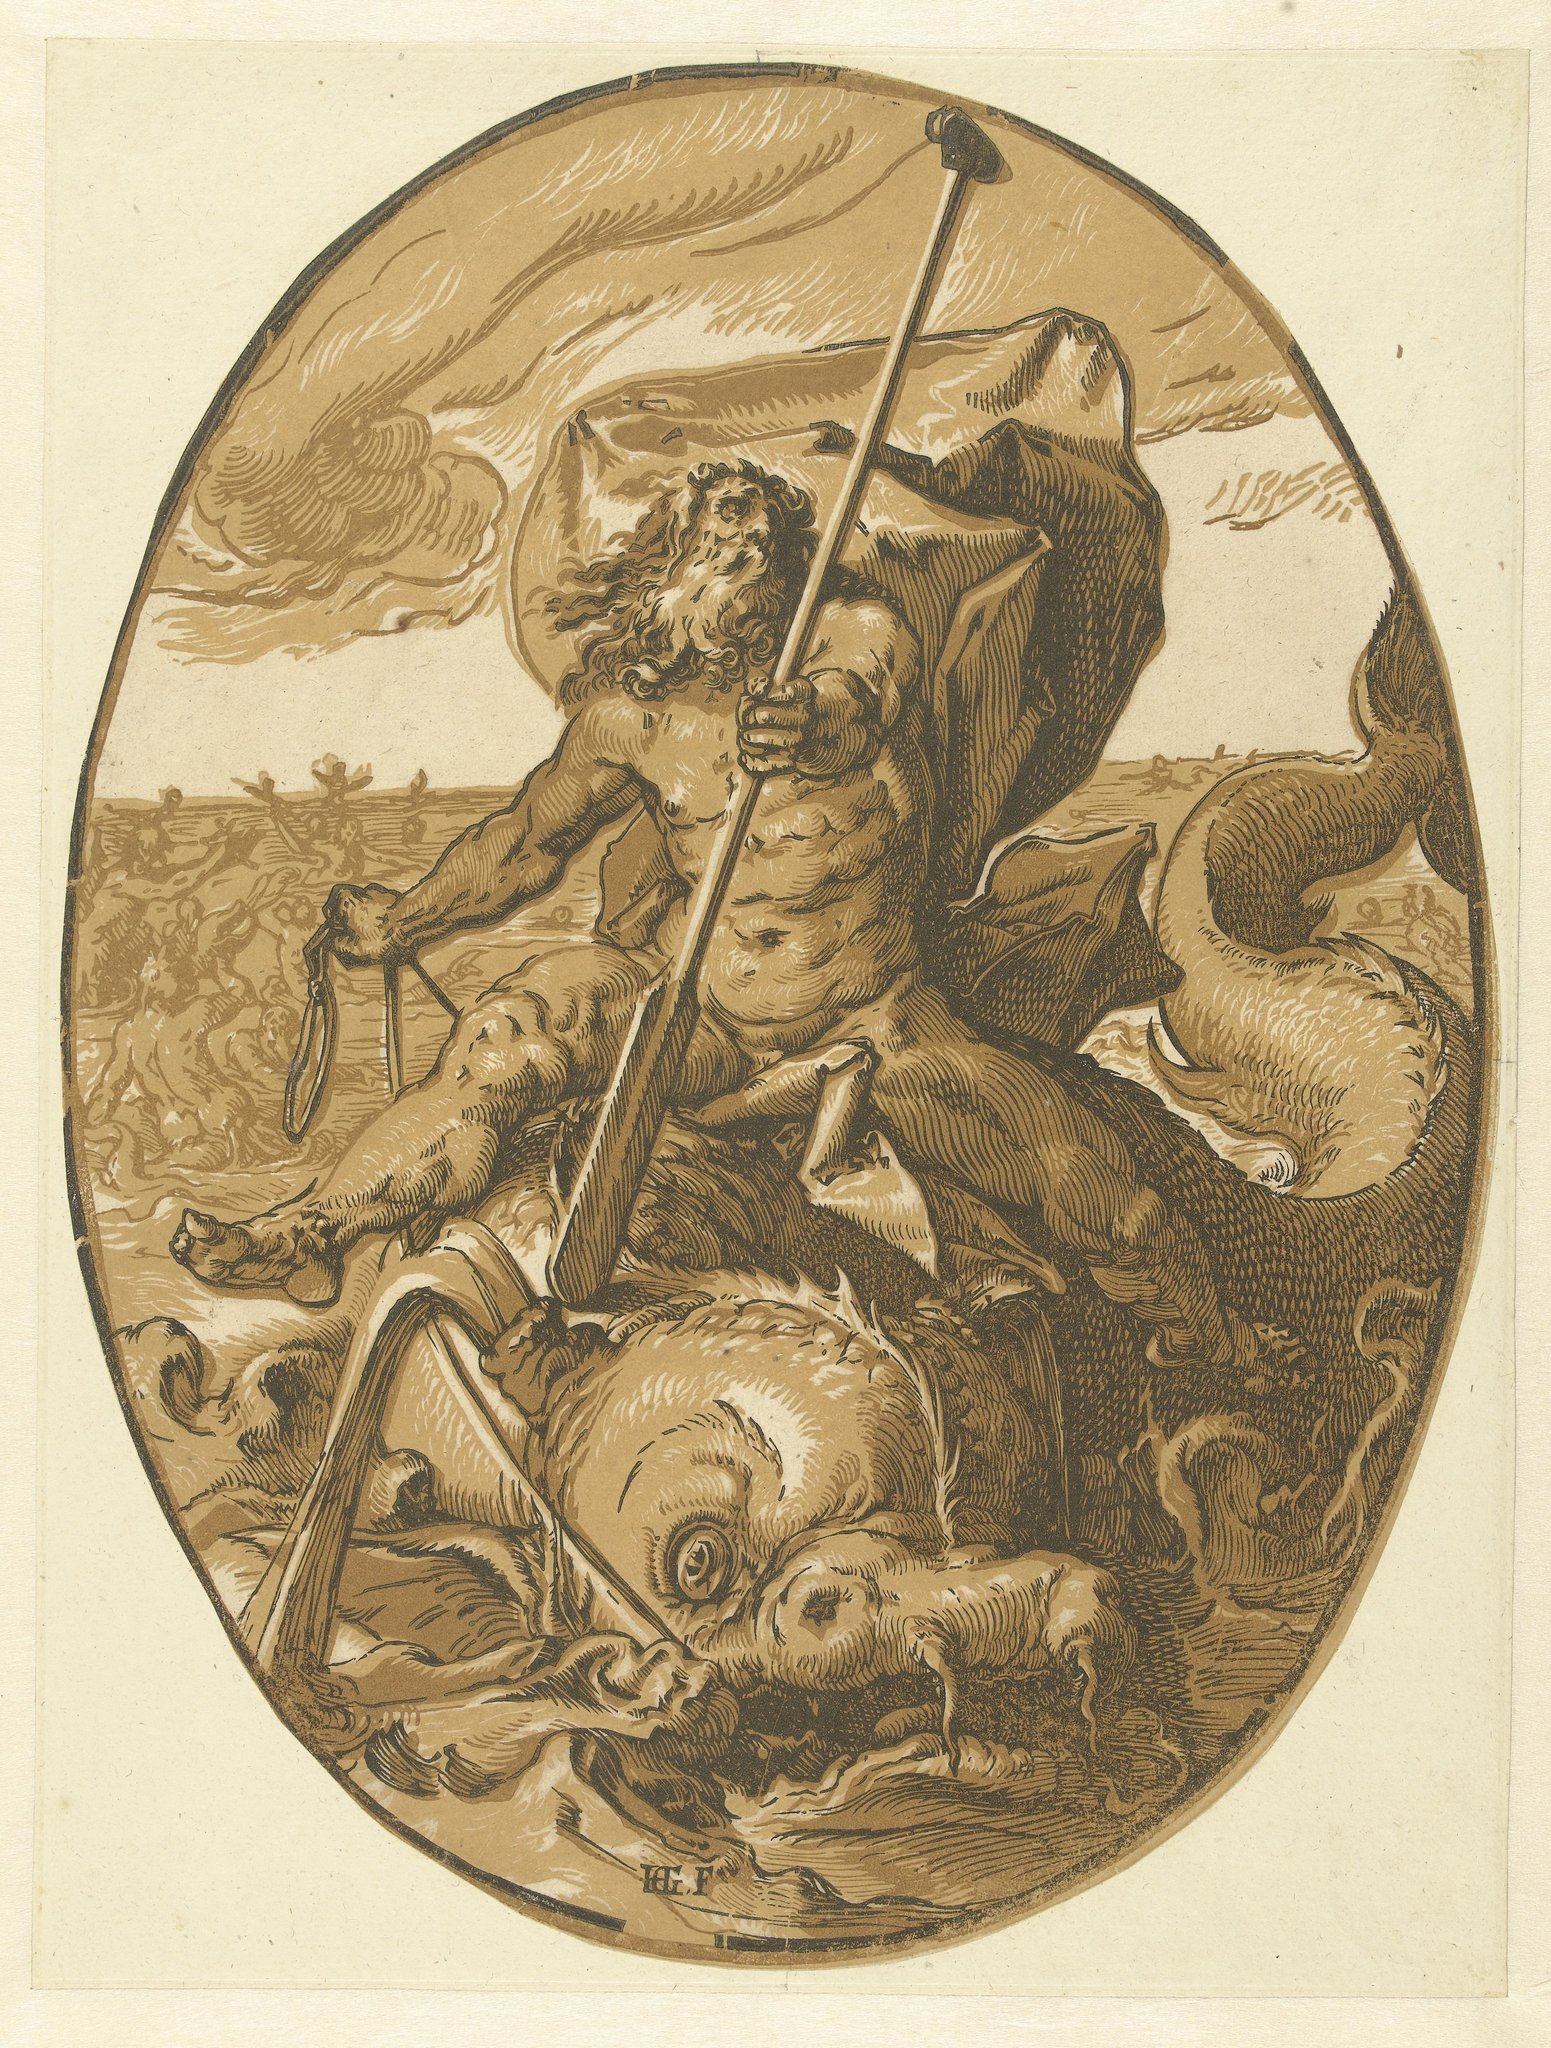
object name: print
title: Goden en godinnen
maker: hendrick goltzius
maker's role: draughtsman, painter, print maker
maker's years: 1558-1617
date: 1589-1590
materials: paper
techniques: woodcut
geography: haarlem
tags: (story of) oceanus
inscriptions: collector's mark: Lugt 240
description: De god Oceanus, gezeten op een grote vis (dolfijn), een roeispaan in de linkerhand. Deze prent is onderdeel van een serie van zeven ovale prenten van klassieke goden en godinnen.